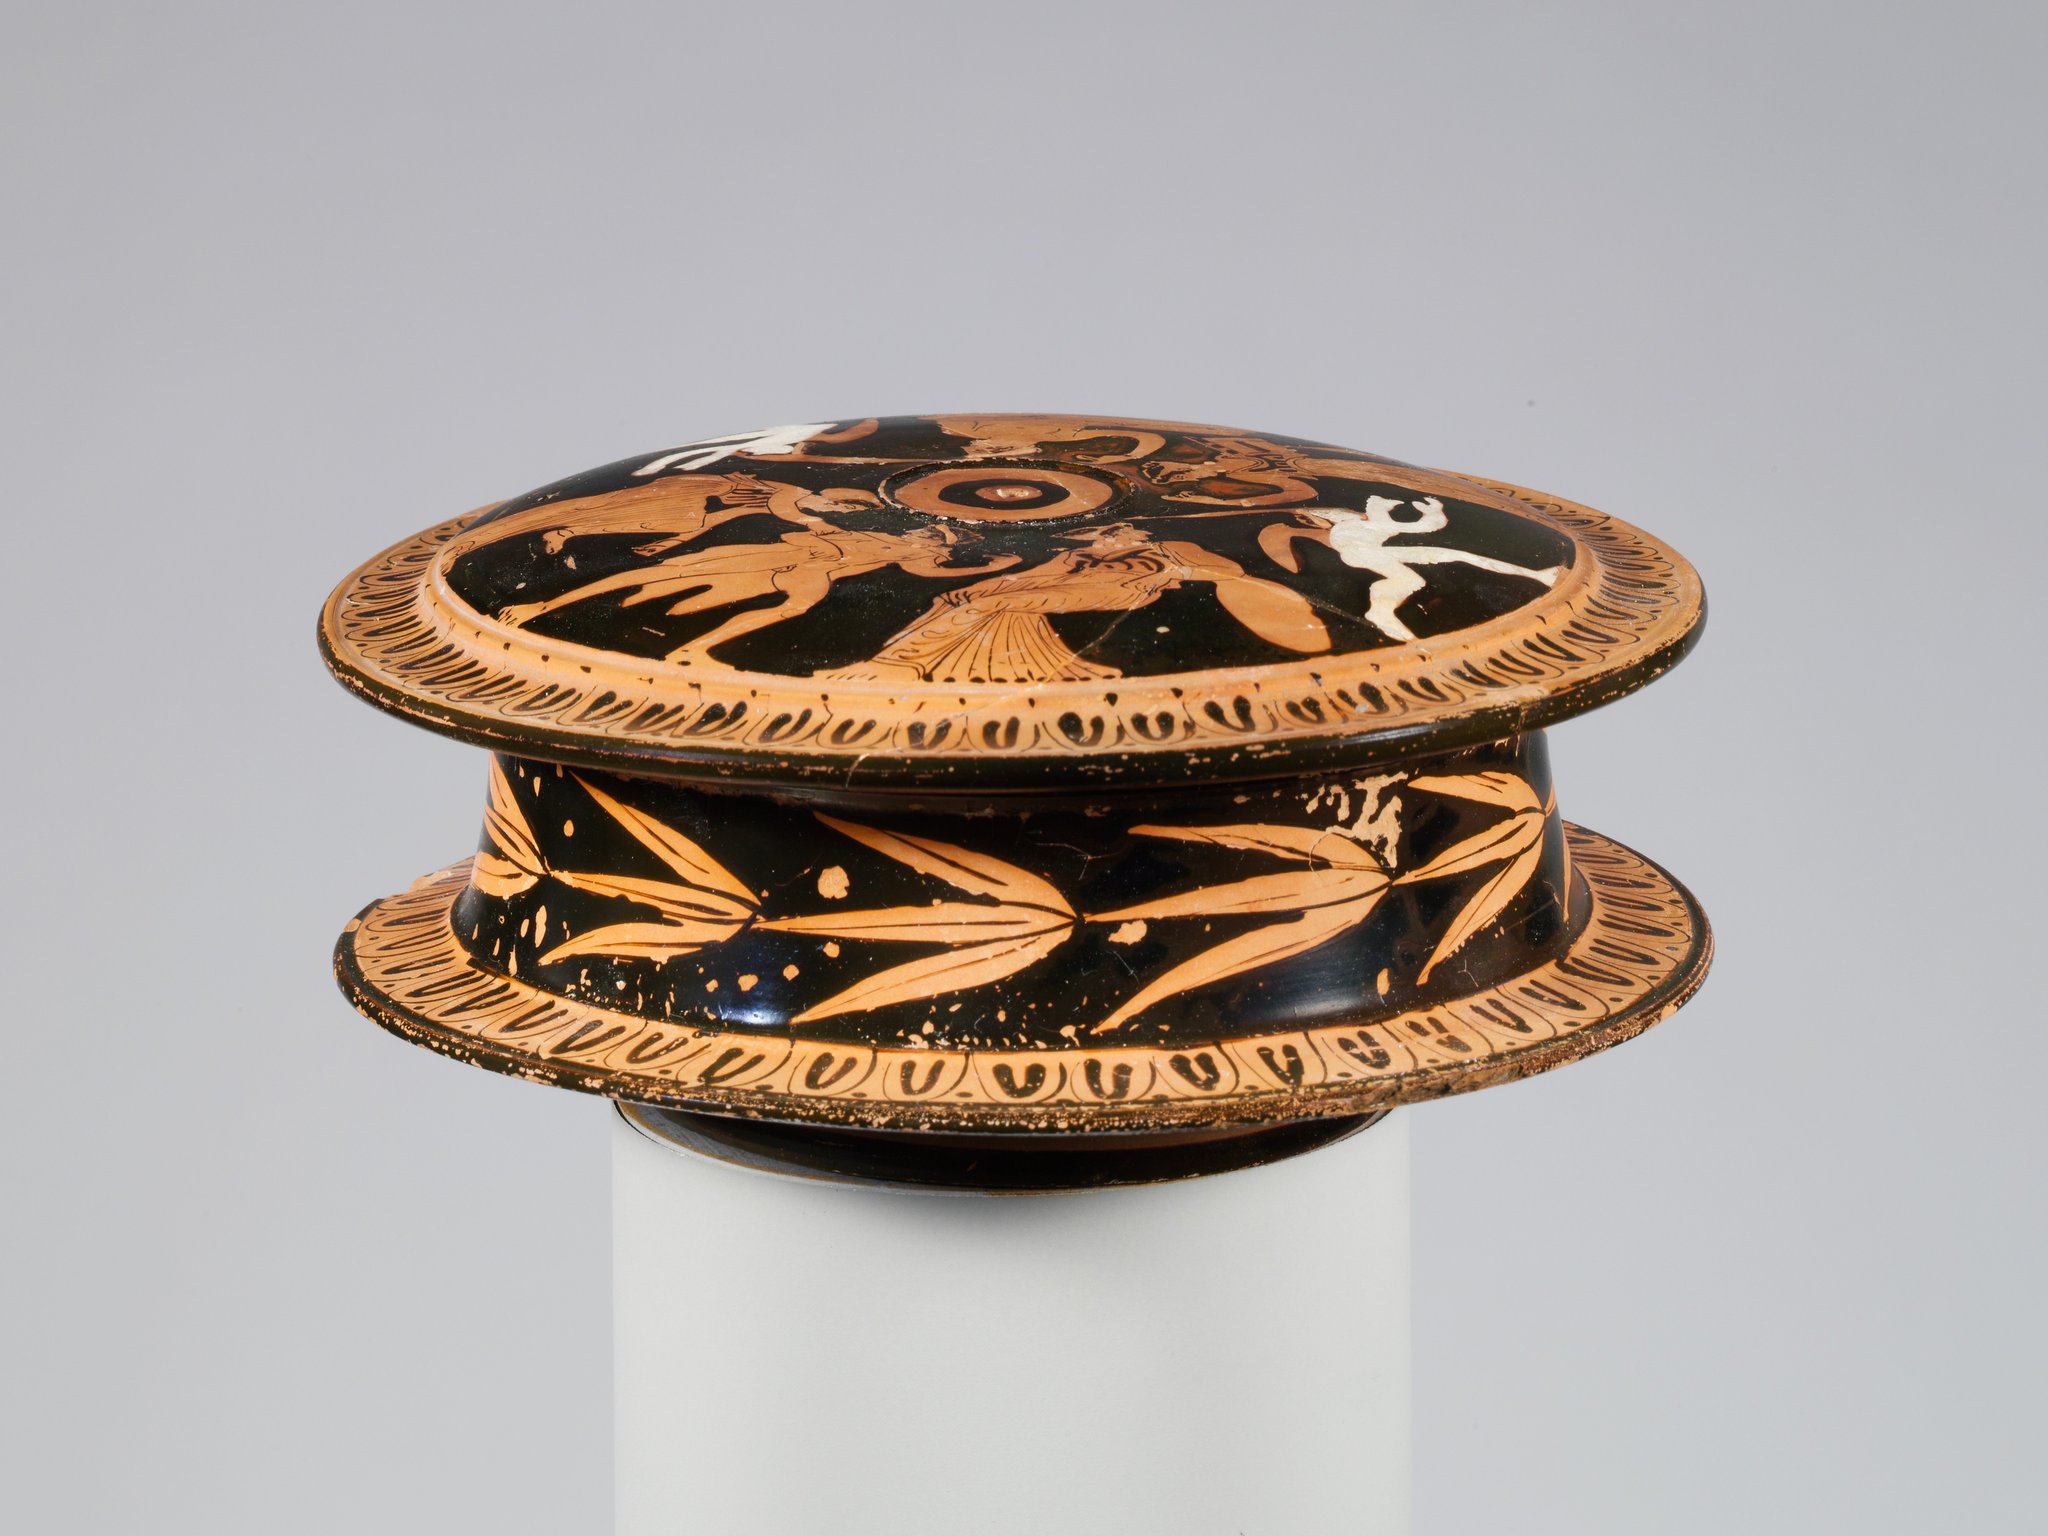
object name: pyxis with lid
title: Terracotta pyxis (box)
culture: greek, attic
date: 400 BCE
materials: terracotta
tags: women,eros